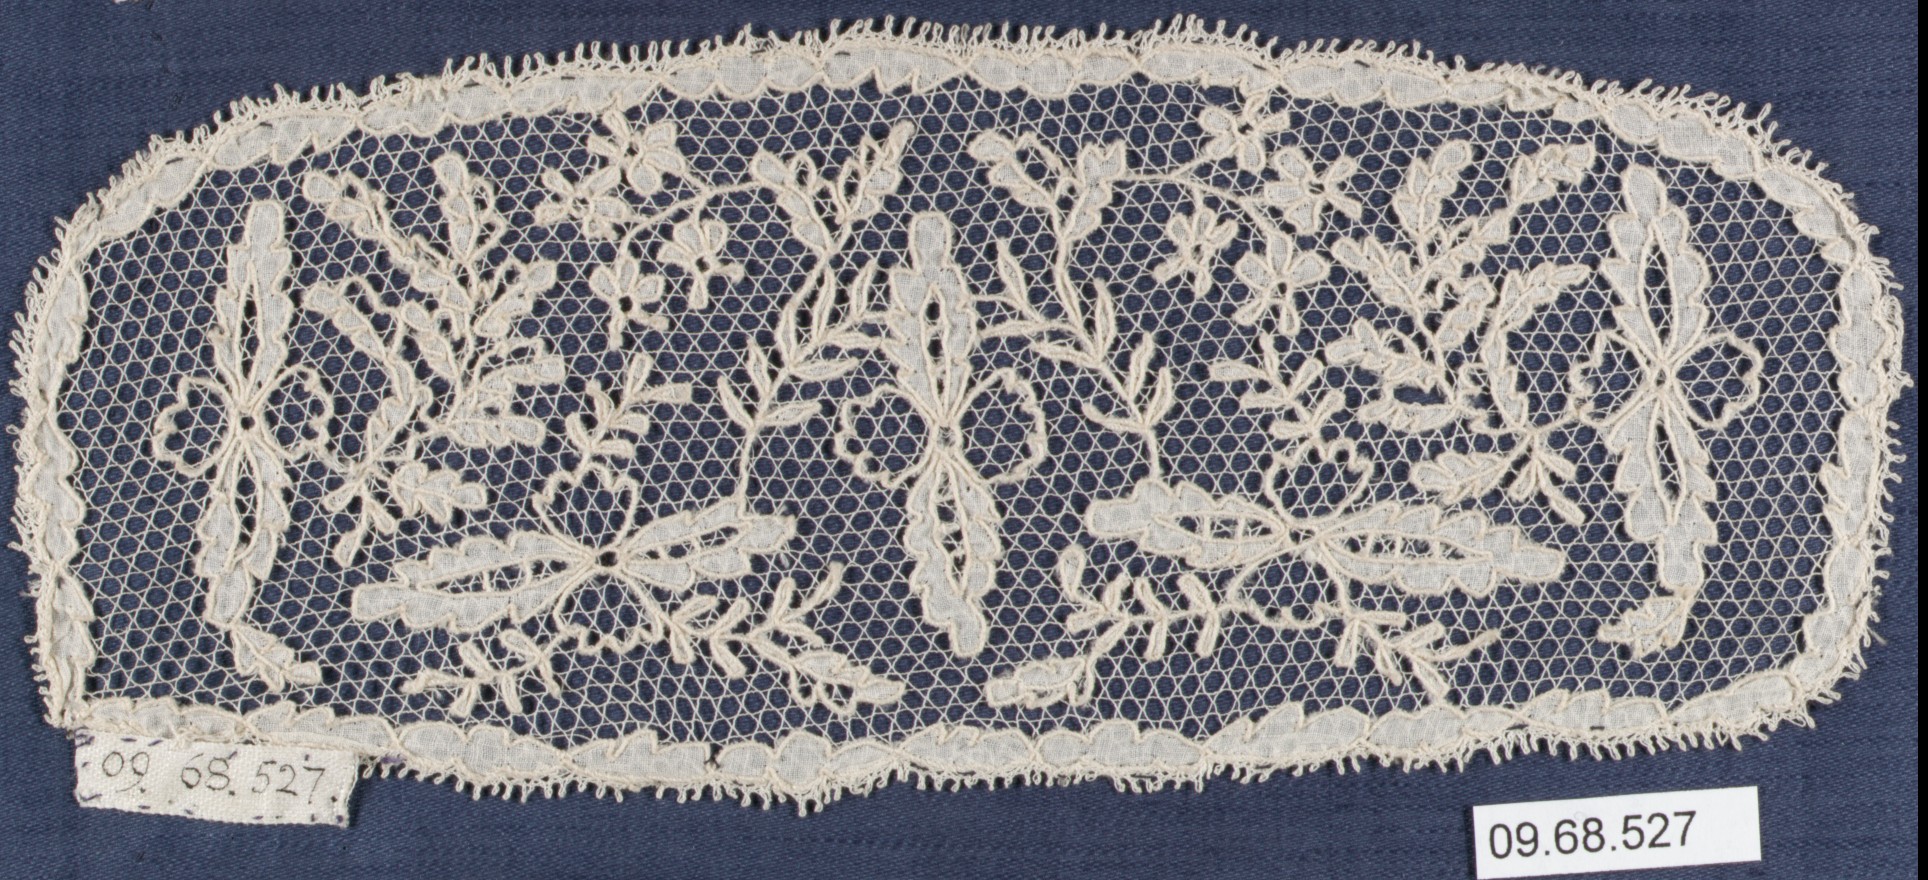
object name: cuff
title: Cuffs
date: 1801-1900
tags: flowers